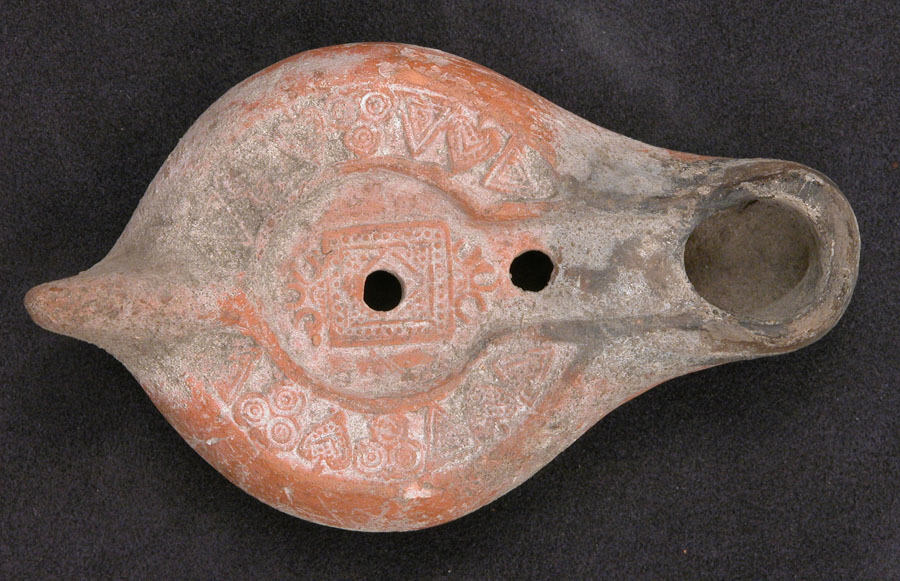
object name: lamp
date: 401-600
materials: earthenware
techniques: molding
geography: egypt